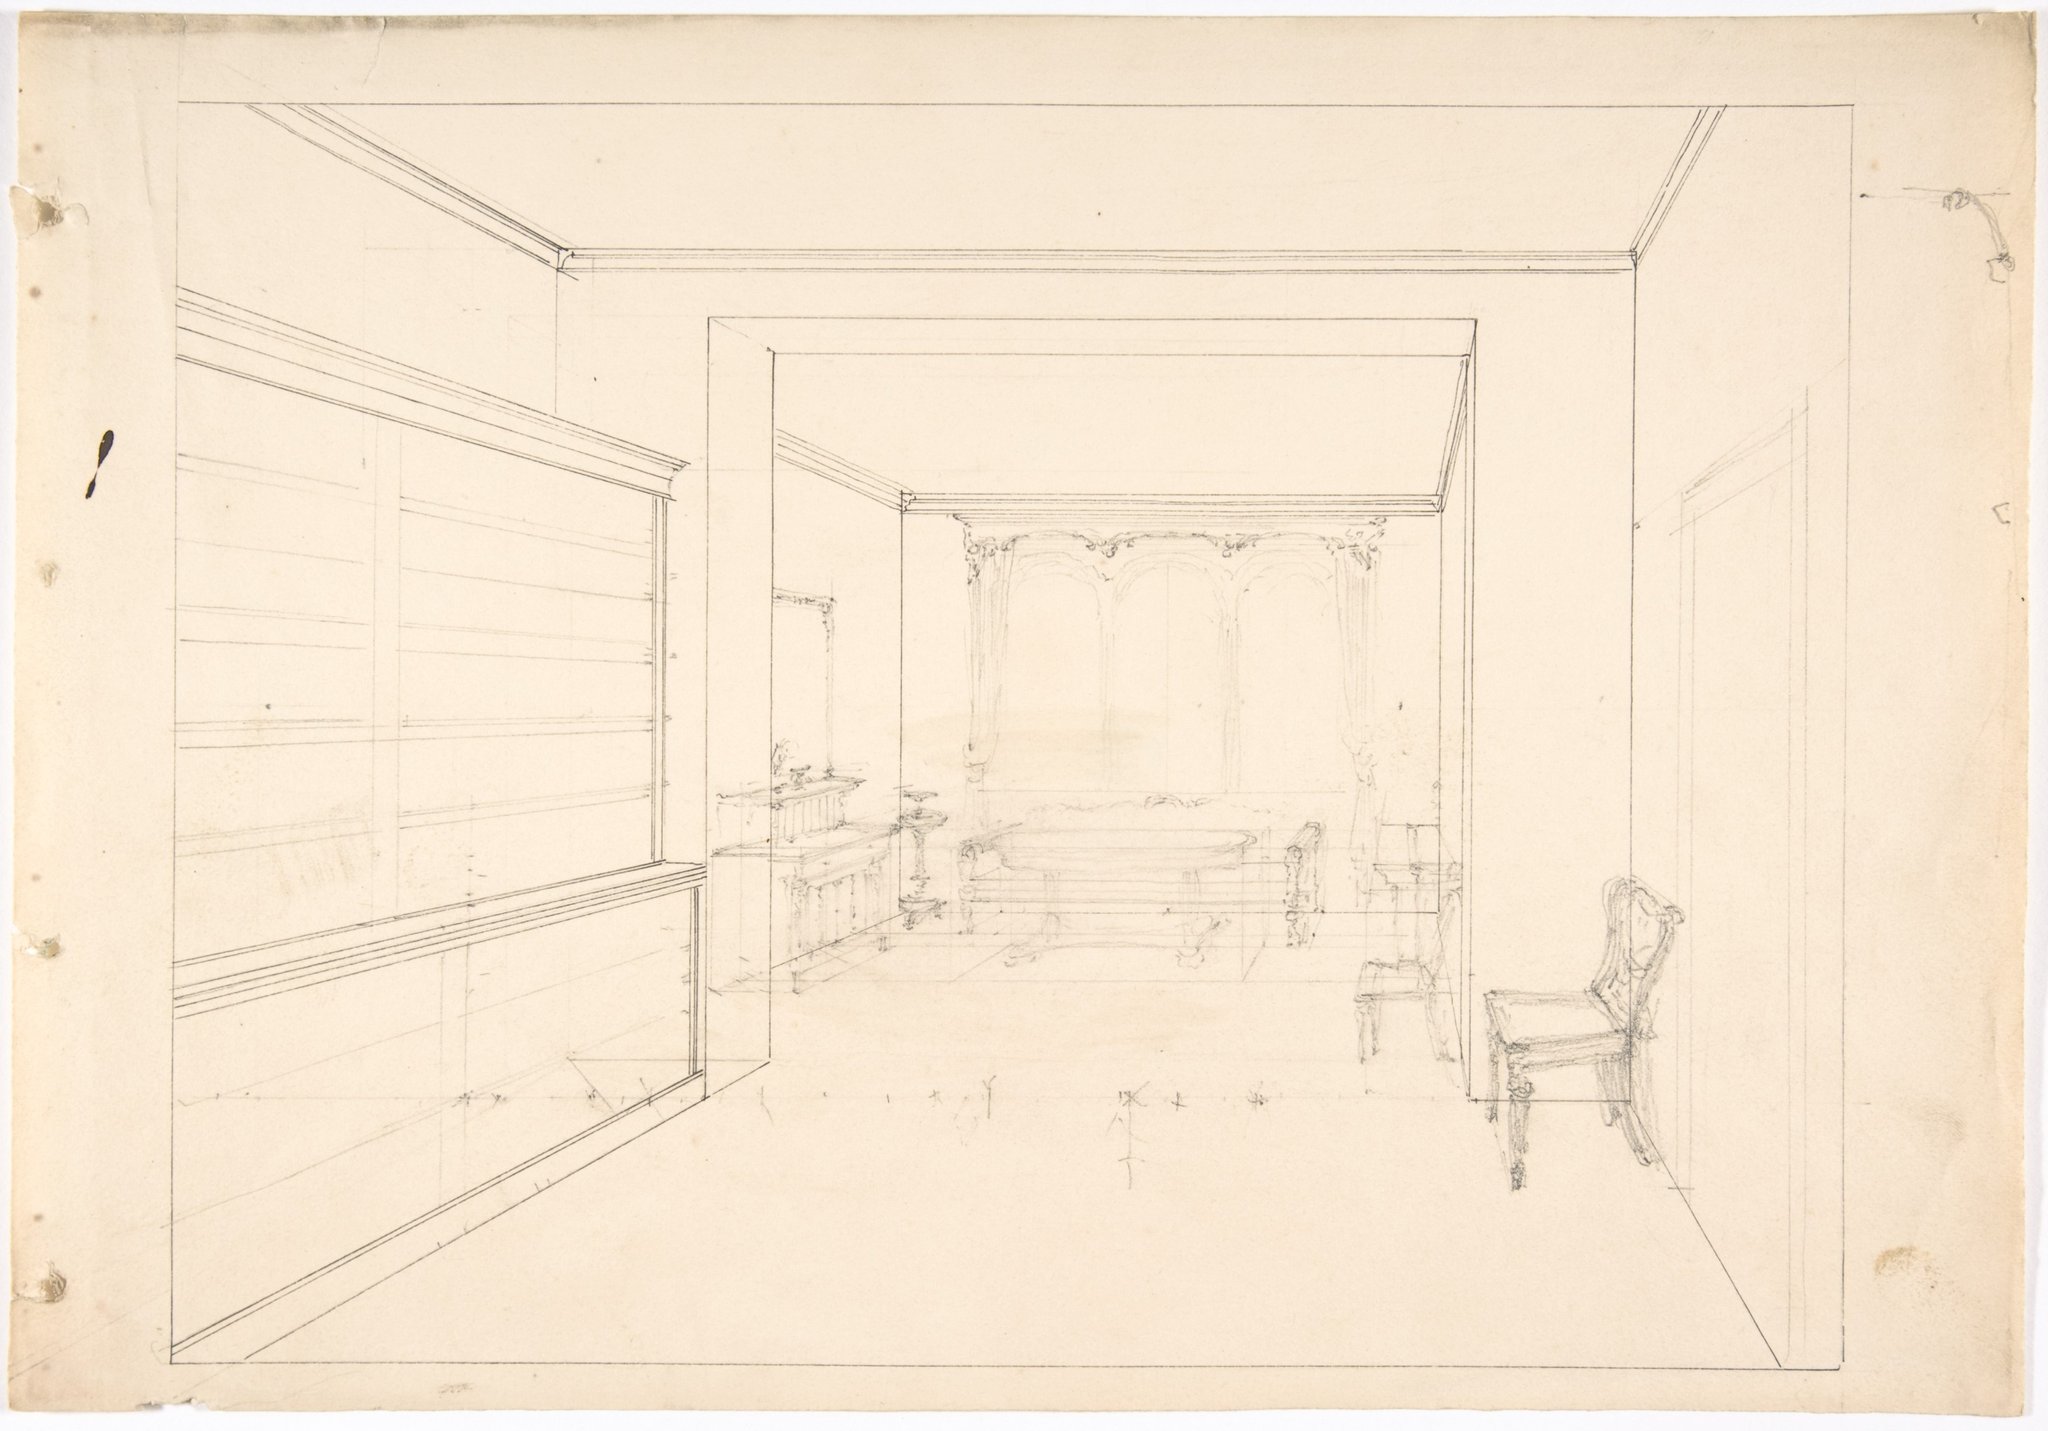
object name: drawing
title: Perspective Drawing of an Interior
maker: anonymous, british, 19th century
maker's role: artist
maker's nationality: british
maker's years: 1800-1900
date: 1801-1833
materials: graphite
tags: interiors